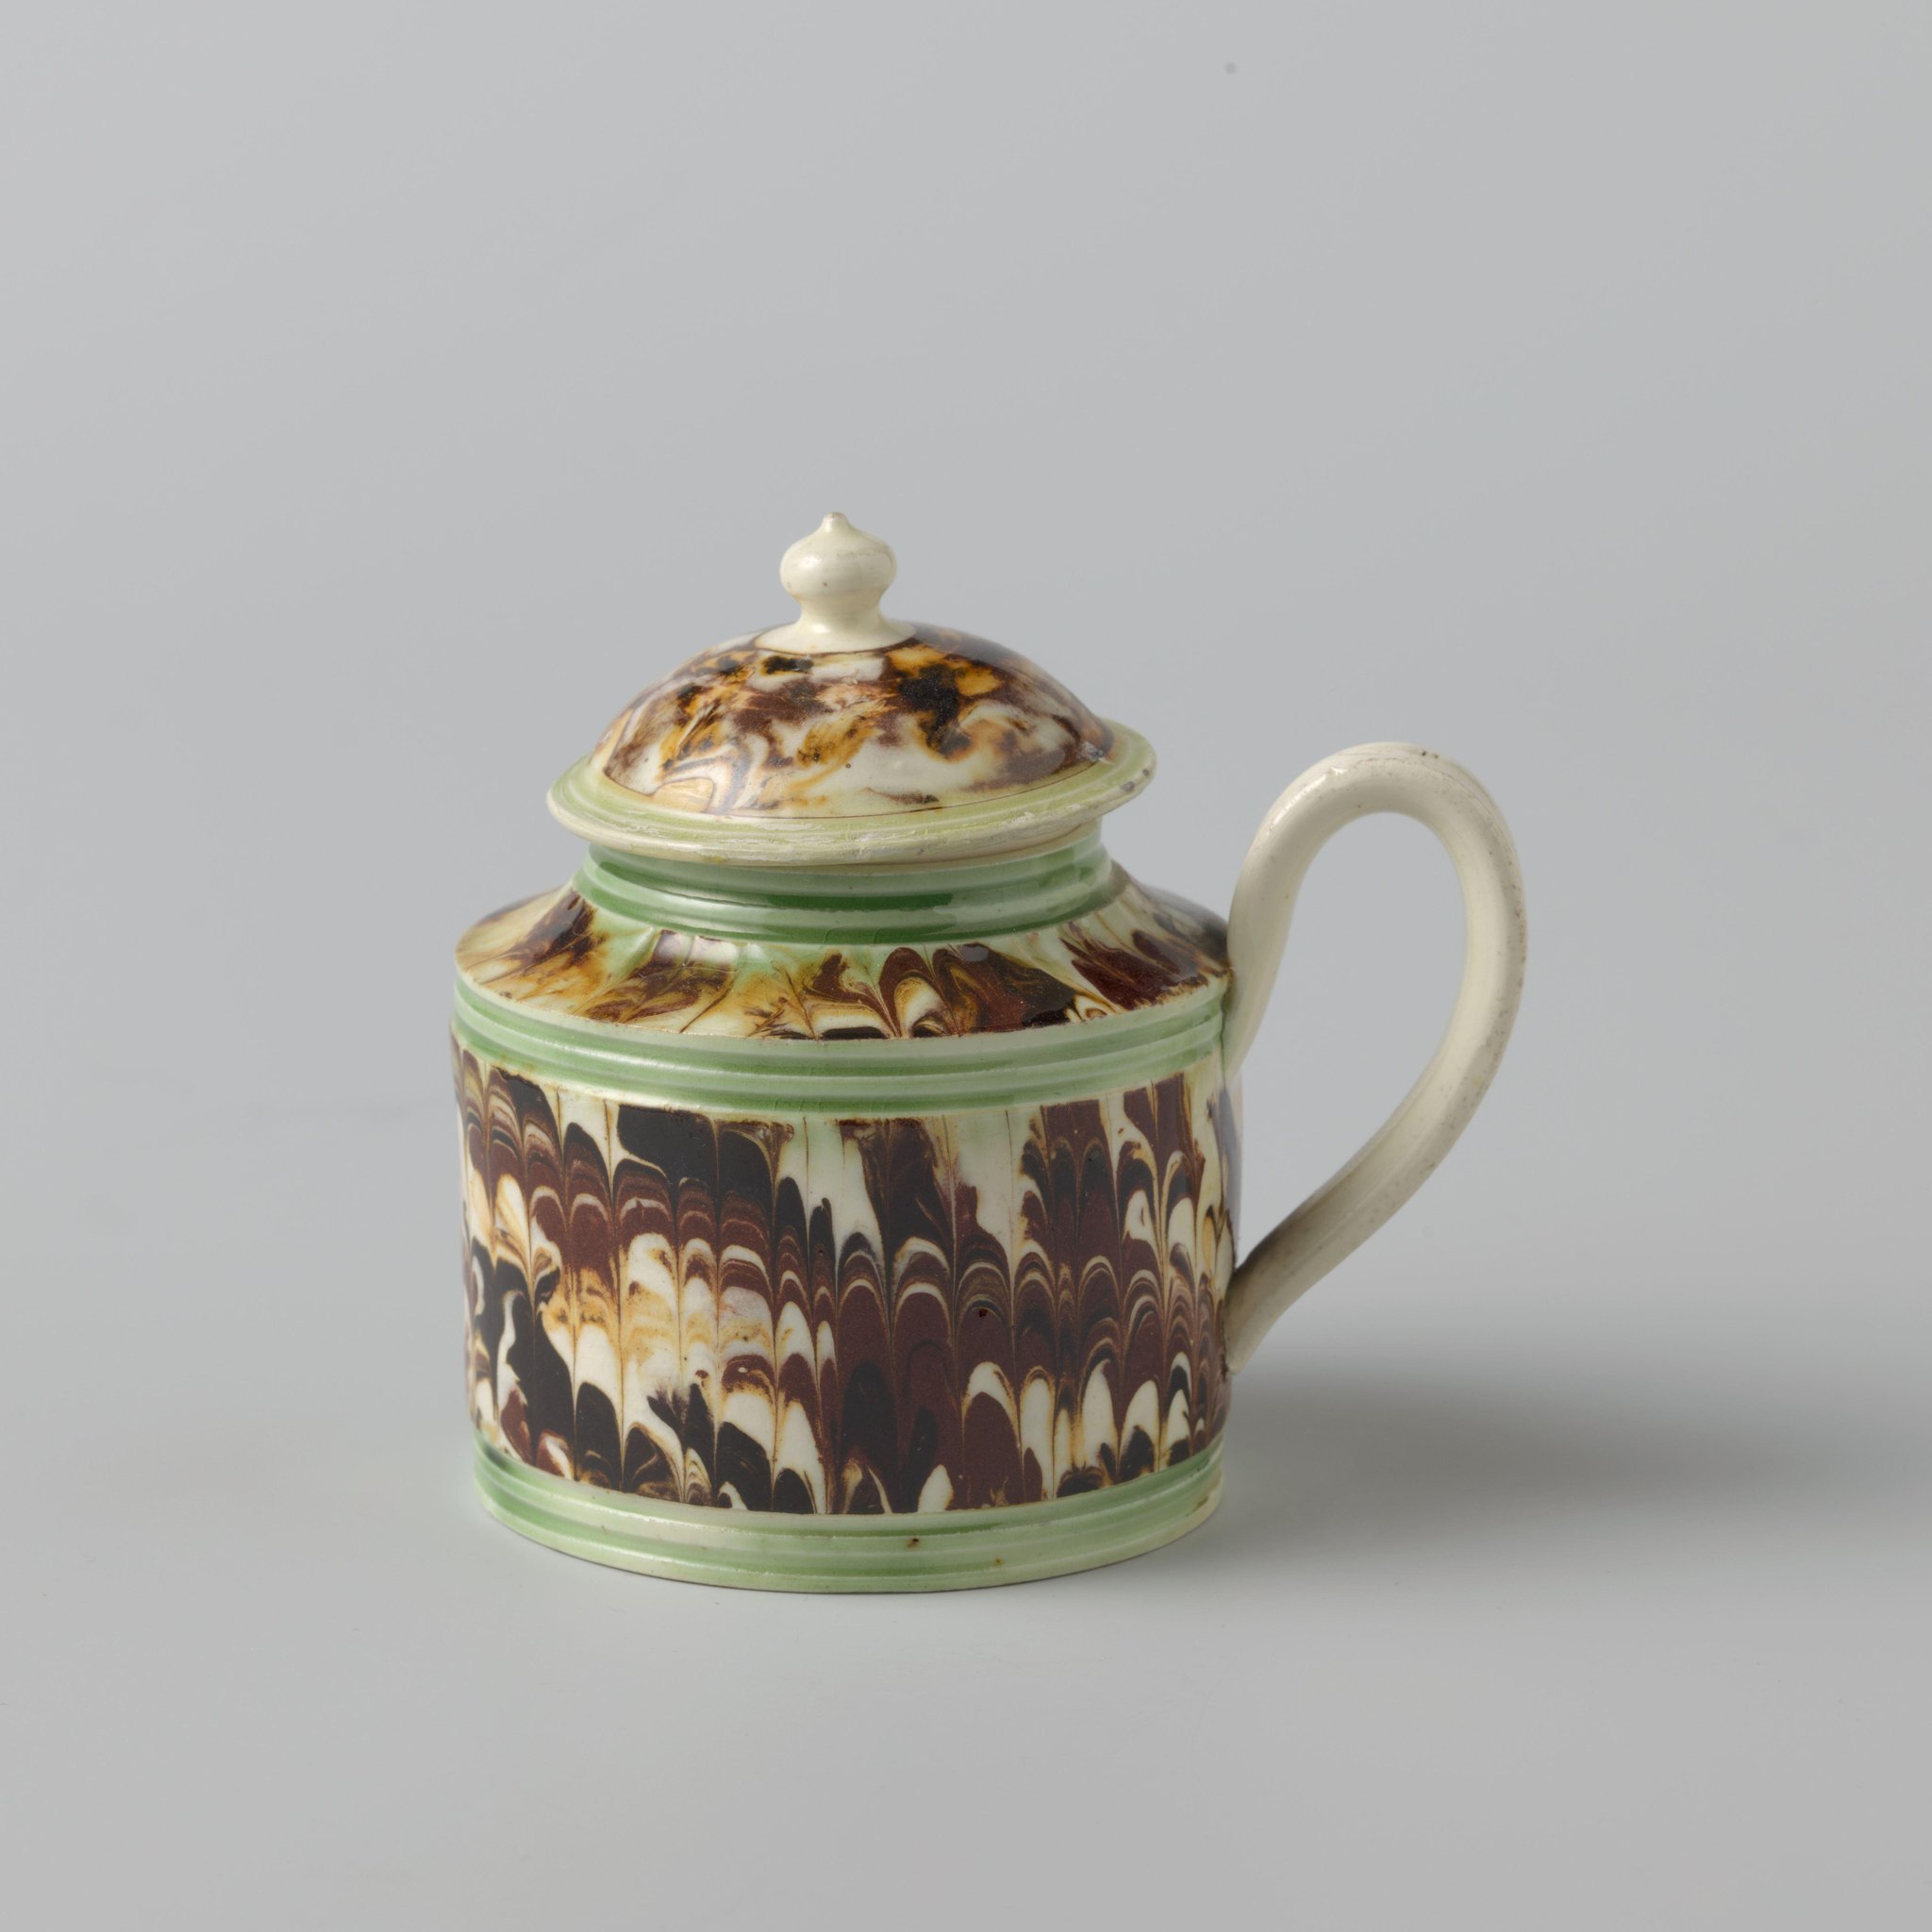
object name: roompot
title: Deksel van mosterdpot of roompot van hardgebakken aardewerk, creamware met gemarmerde decoratie.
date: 1778-1786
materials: earthenware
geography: staffordshire